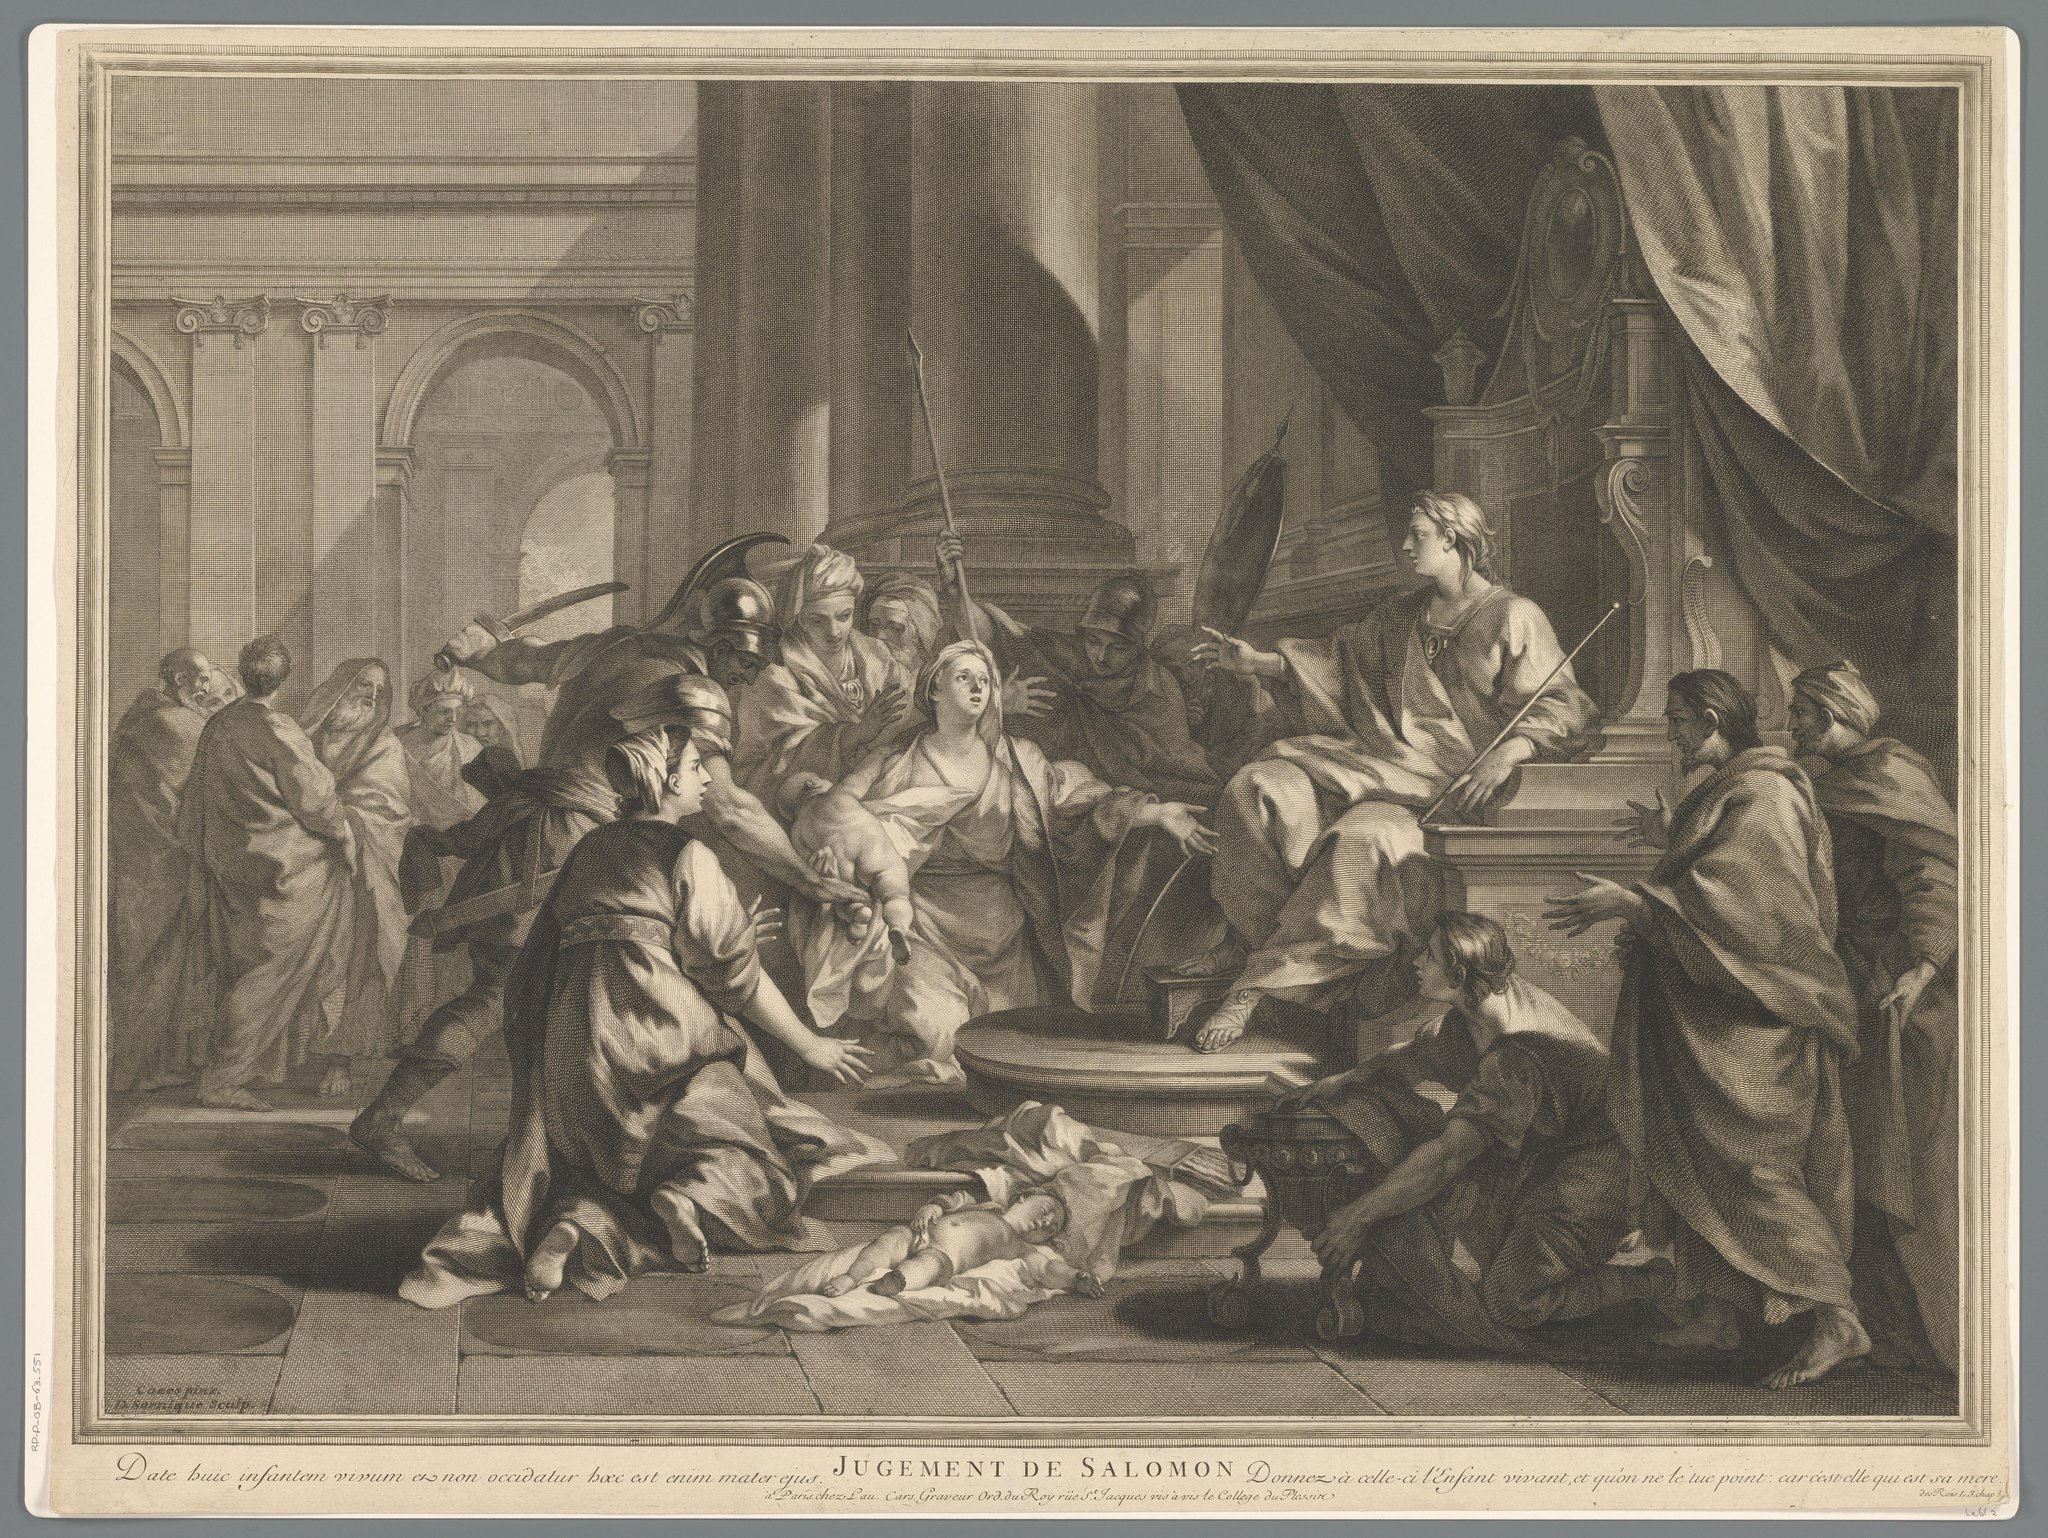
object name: print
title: Oordeel van Salomo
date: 1717-1756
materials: paper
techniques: engraving, etching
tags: solomon gives verdict; he commands a soldier to divide the living child in two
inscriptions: collector's mark: Lugt 240